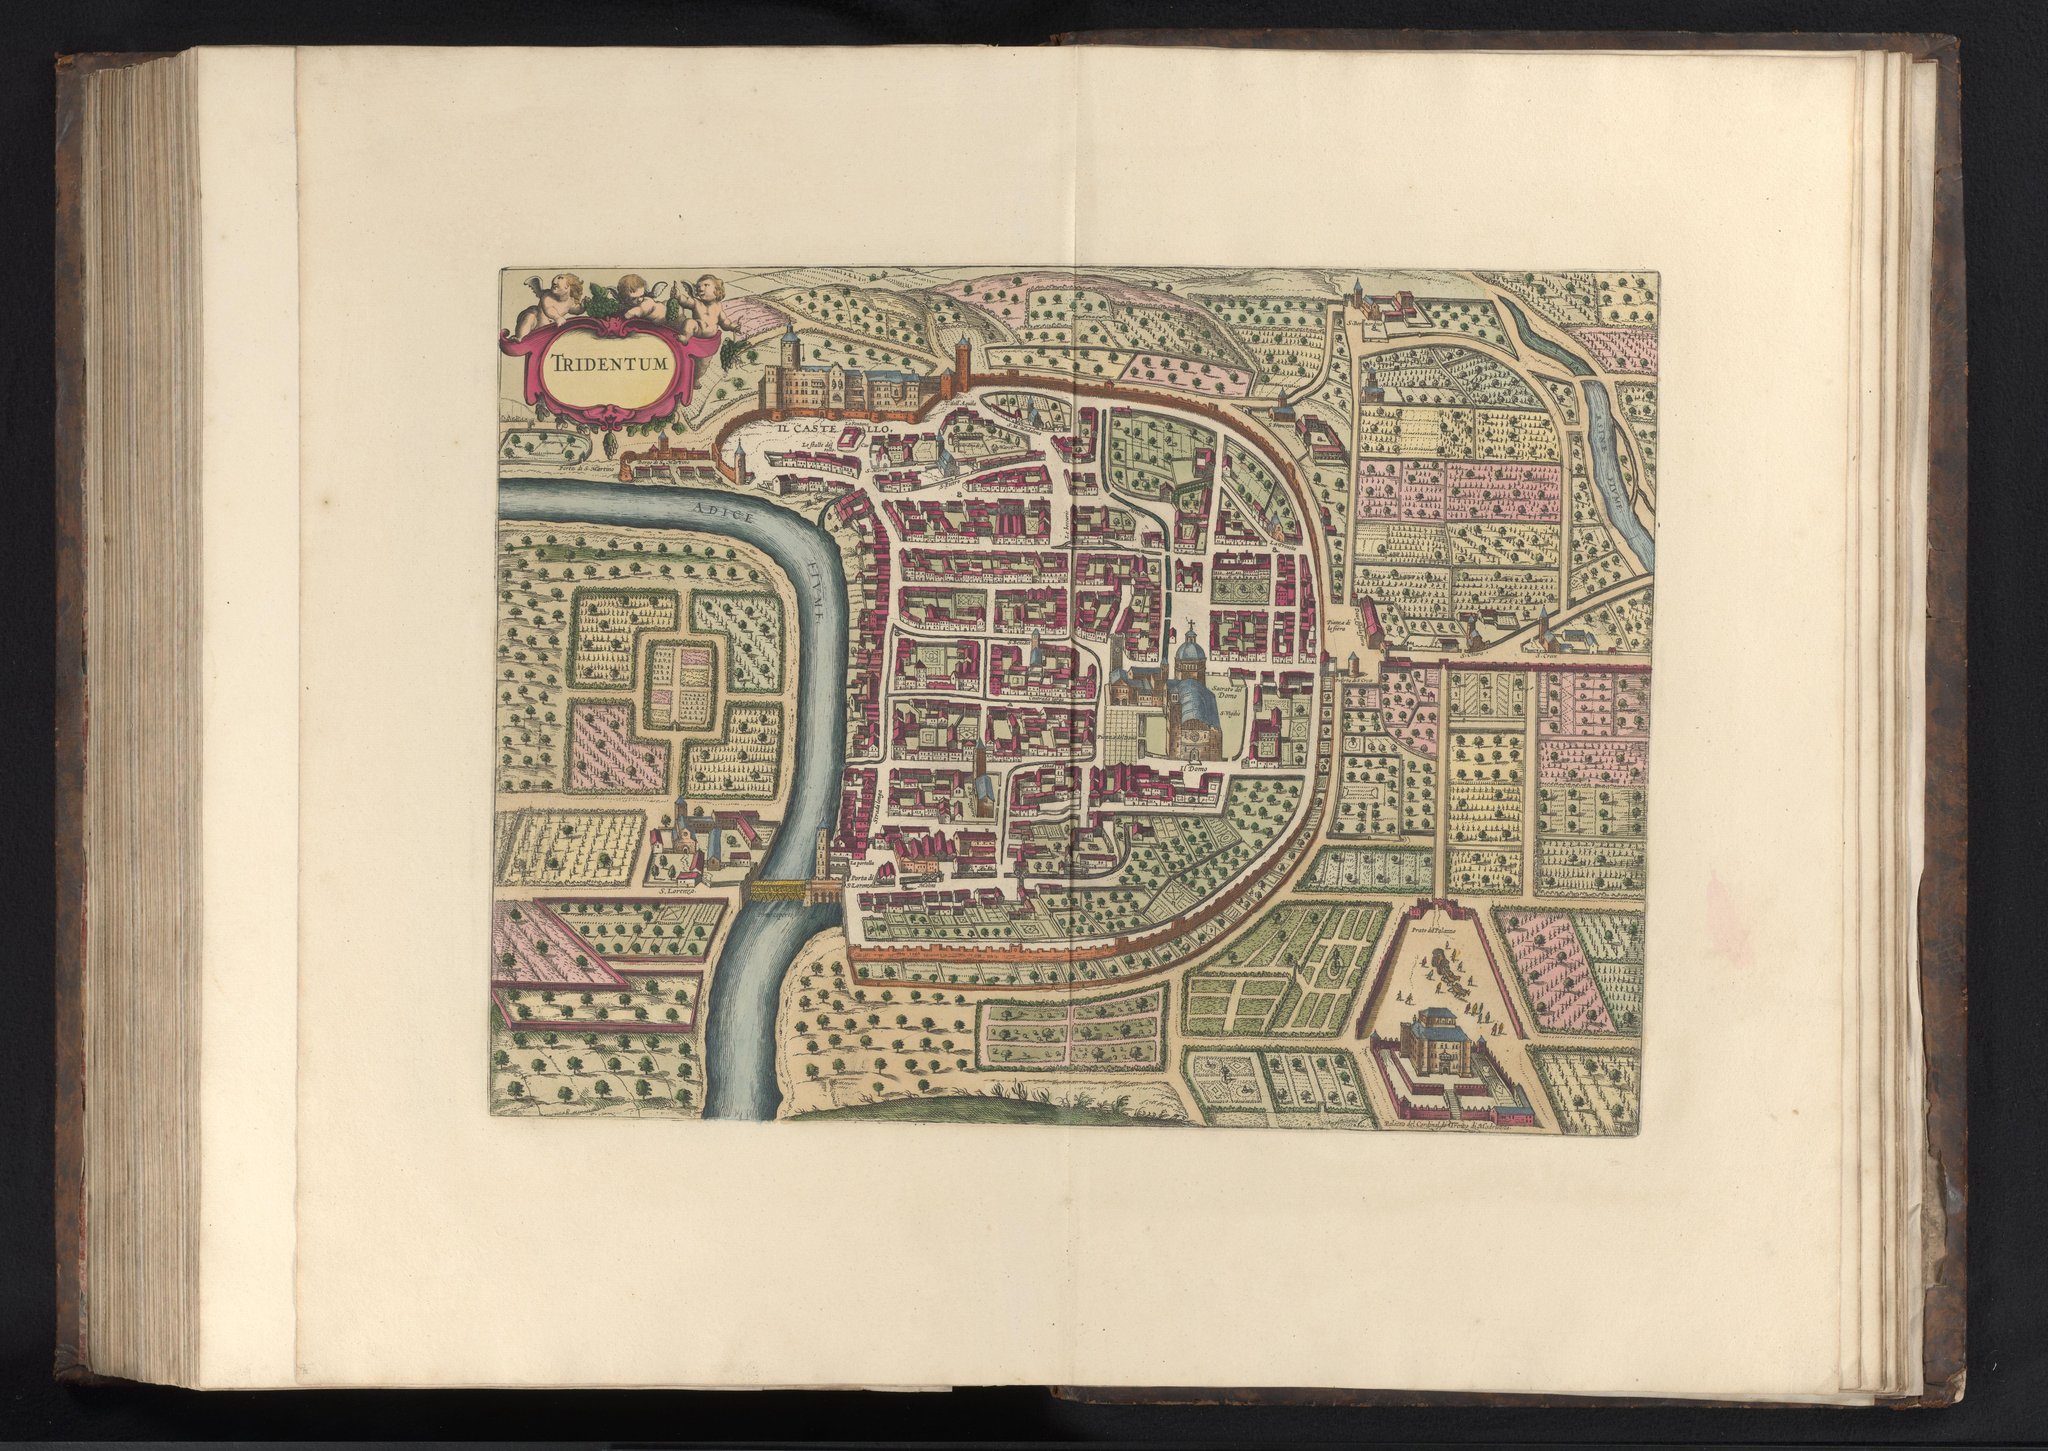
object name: print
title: Gezicht op Trente in vogelvluchtperspectief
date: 1600-1699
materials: paper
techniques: colour, etching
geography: the hague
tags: bird's eye view ~ architectural design or model, maps of cities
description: Gezicht op Trente in vogelvluchtperspectief. Linksboven een cartouche met titel en drie putti. Prent maakt deel uit van een album.